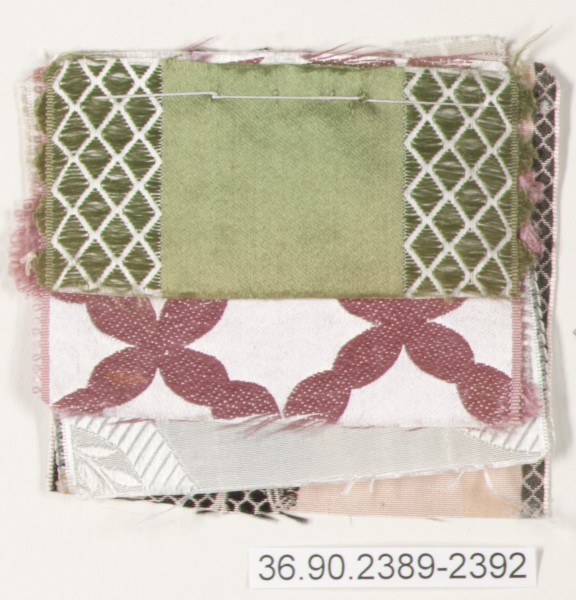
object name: ribbon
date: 1801-1900